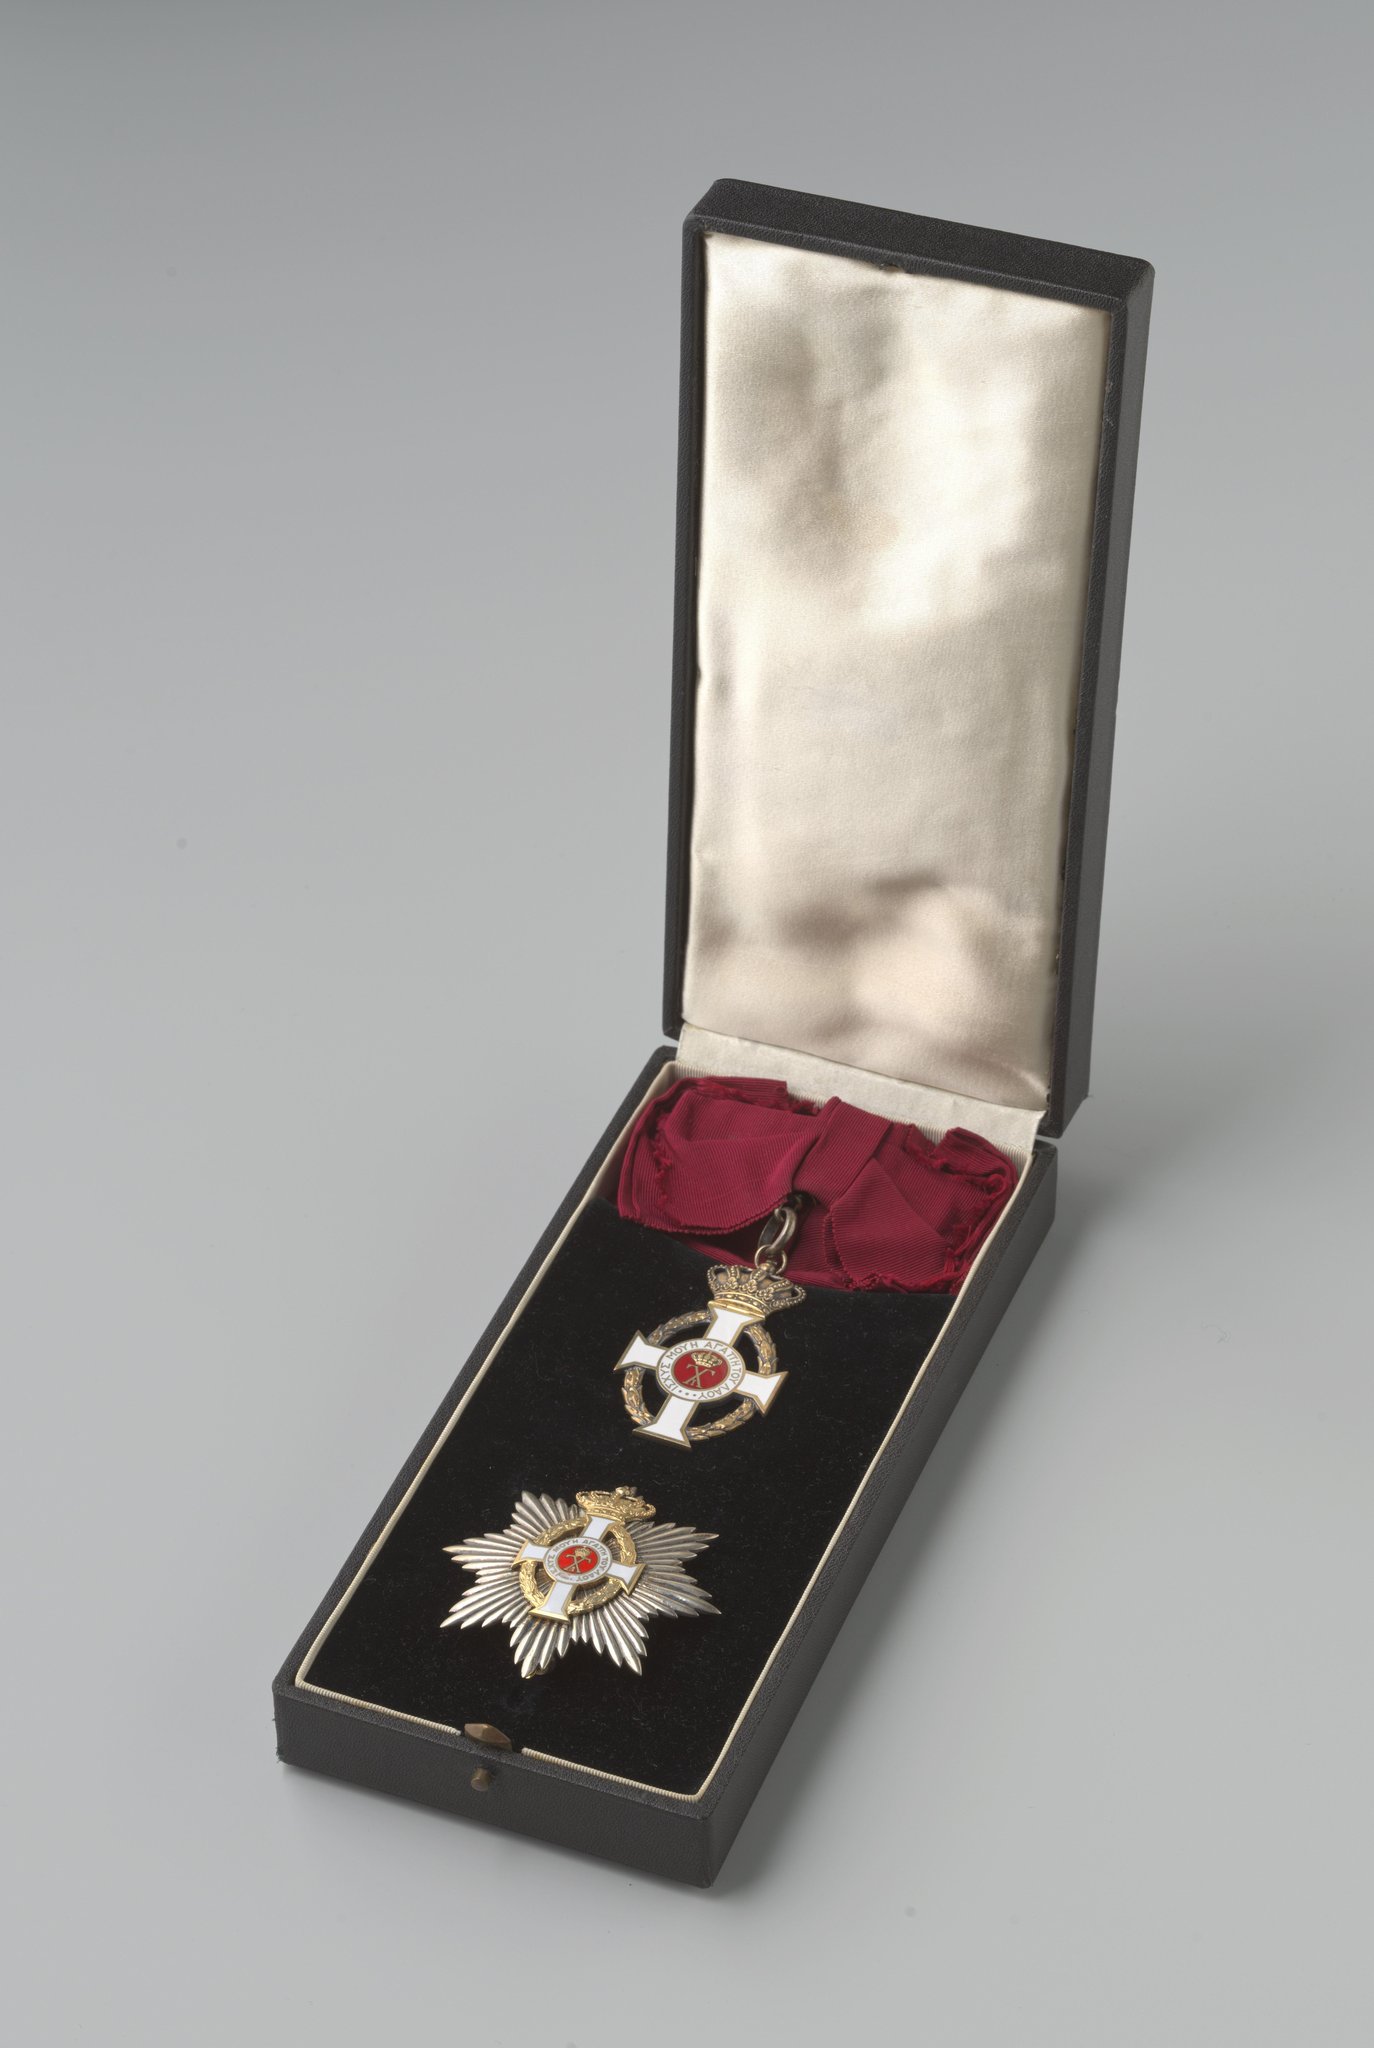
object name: blotter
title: Griekse orde (Orde van George I), ontvangen door Willem Drees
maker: Anonymous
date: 1954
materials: gold, silver, textile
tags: amsterdam, the hague, willem drees, netherlands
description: Het ordeteken is een open wit geemailleerd Latijns kruis in goud, met een laurierkrans tussen de kruisarmen, dat door een koningskroon gedragen wordt. In het midden van het kruis in medaillonvorm het ronde spiegelmonogram van koning George I op een rode ondergrond met als omschrift in goud op een witte ondergrond 'Iskhys moy e agape toy laou' ('De liefde van het volk is mijn kracht'). Het ordeteken is bevestigd aan een donkerrode schouderband.